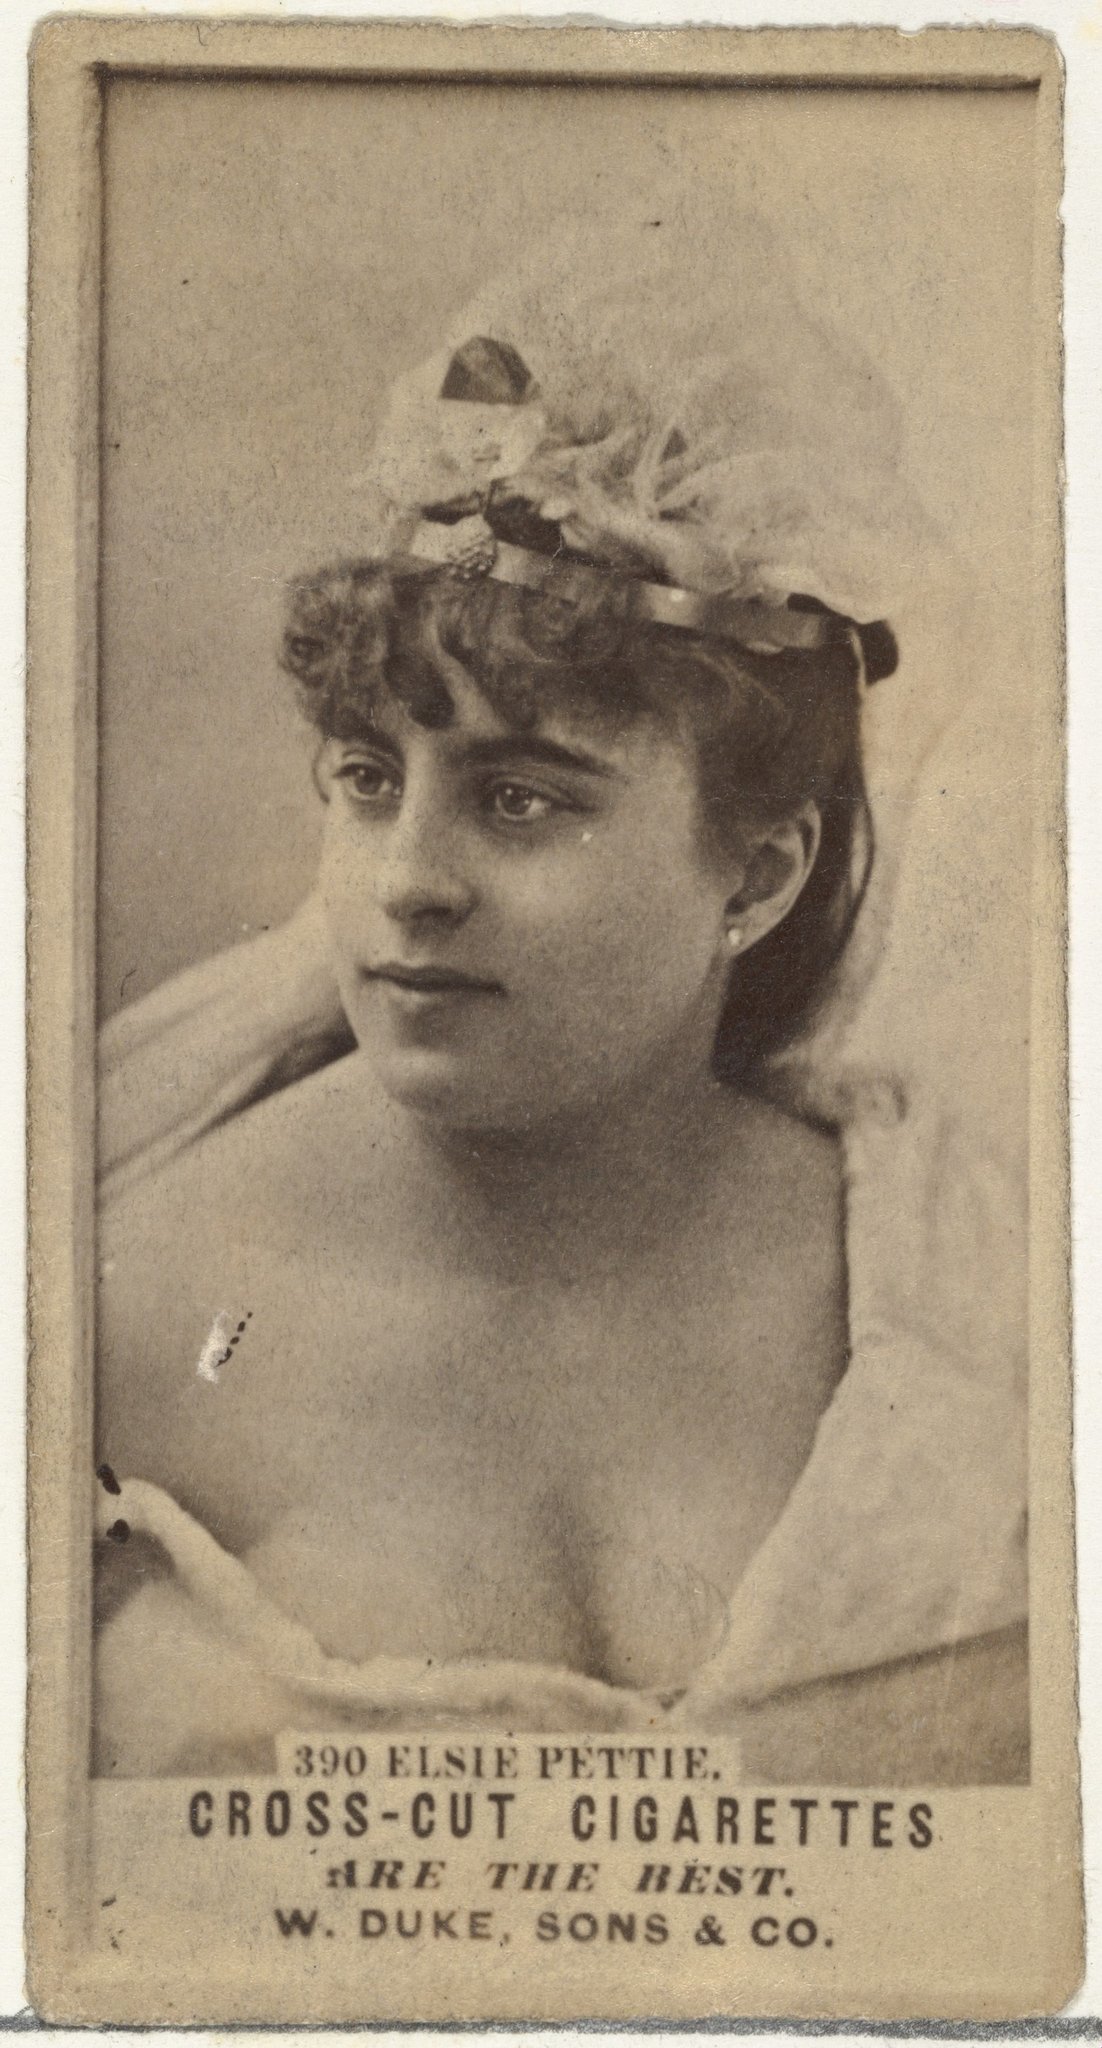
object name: photograph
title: Card Number 390, Elsie Pettie, from the Actors and Actresses series (N145-3) issued by Duke Sons & Co. to promote Cross Cut Cigarettes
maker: w. duke, sons & co.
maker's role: publisher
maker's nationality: american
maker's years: 1870-1920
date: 1880-1889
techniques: albumen silver print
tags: portraits,women,actresses